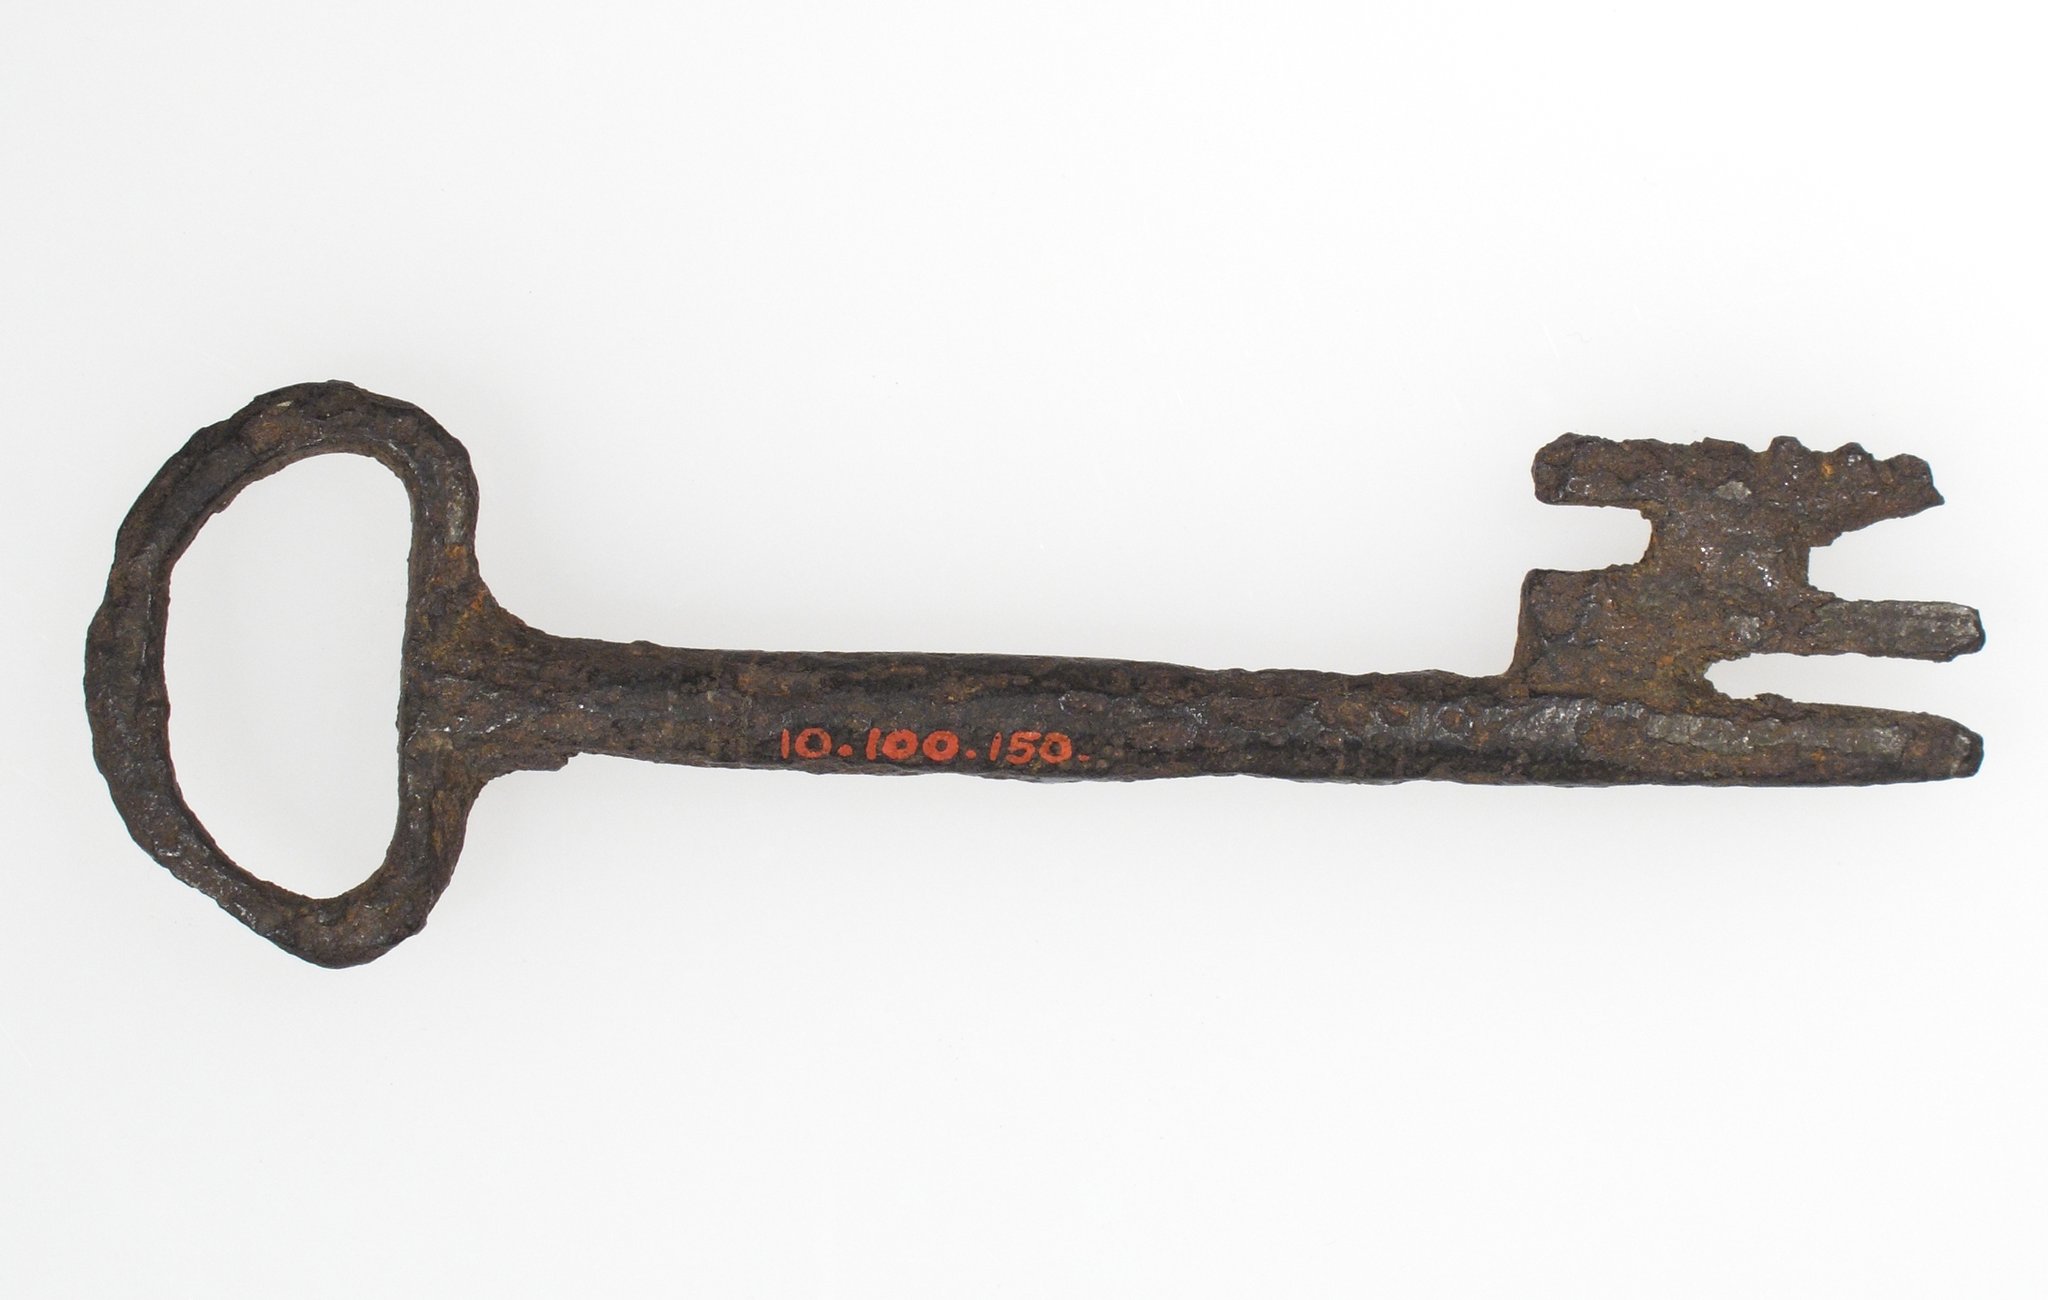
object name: key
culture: european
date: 1401-1600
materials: iron